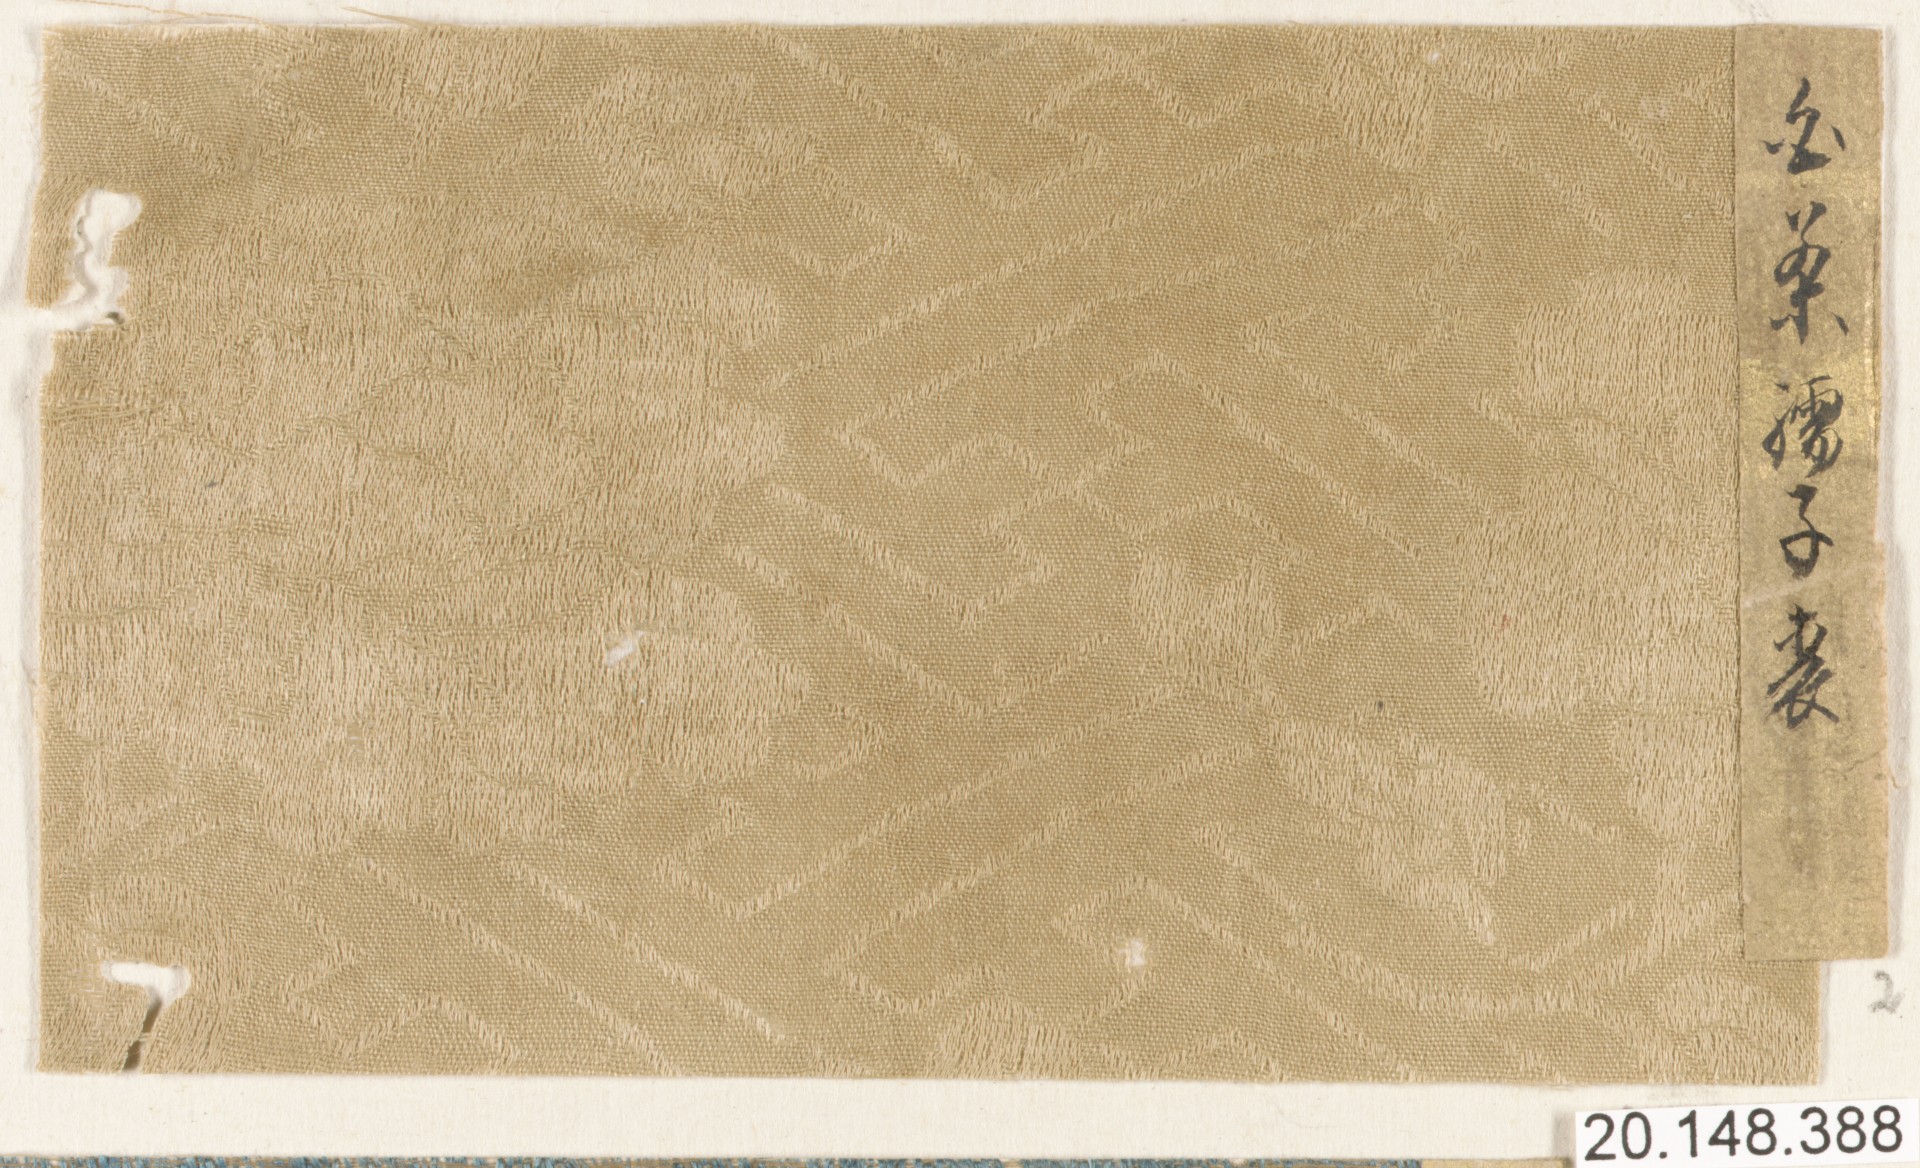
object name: piece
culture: chinese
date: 1601-1700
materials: silk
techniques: compound weave